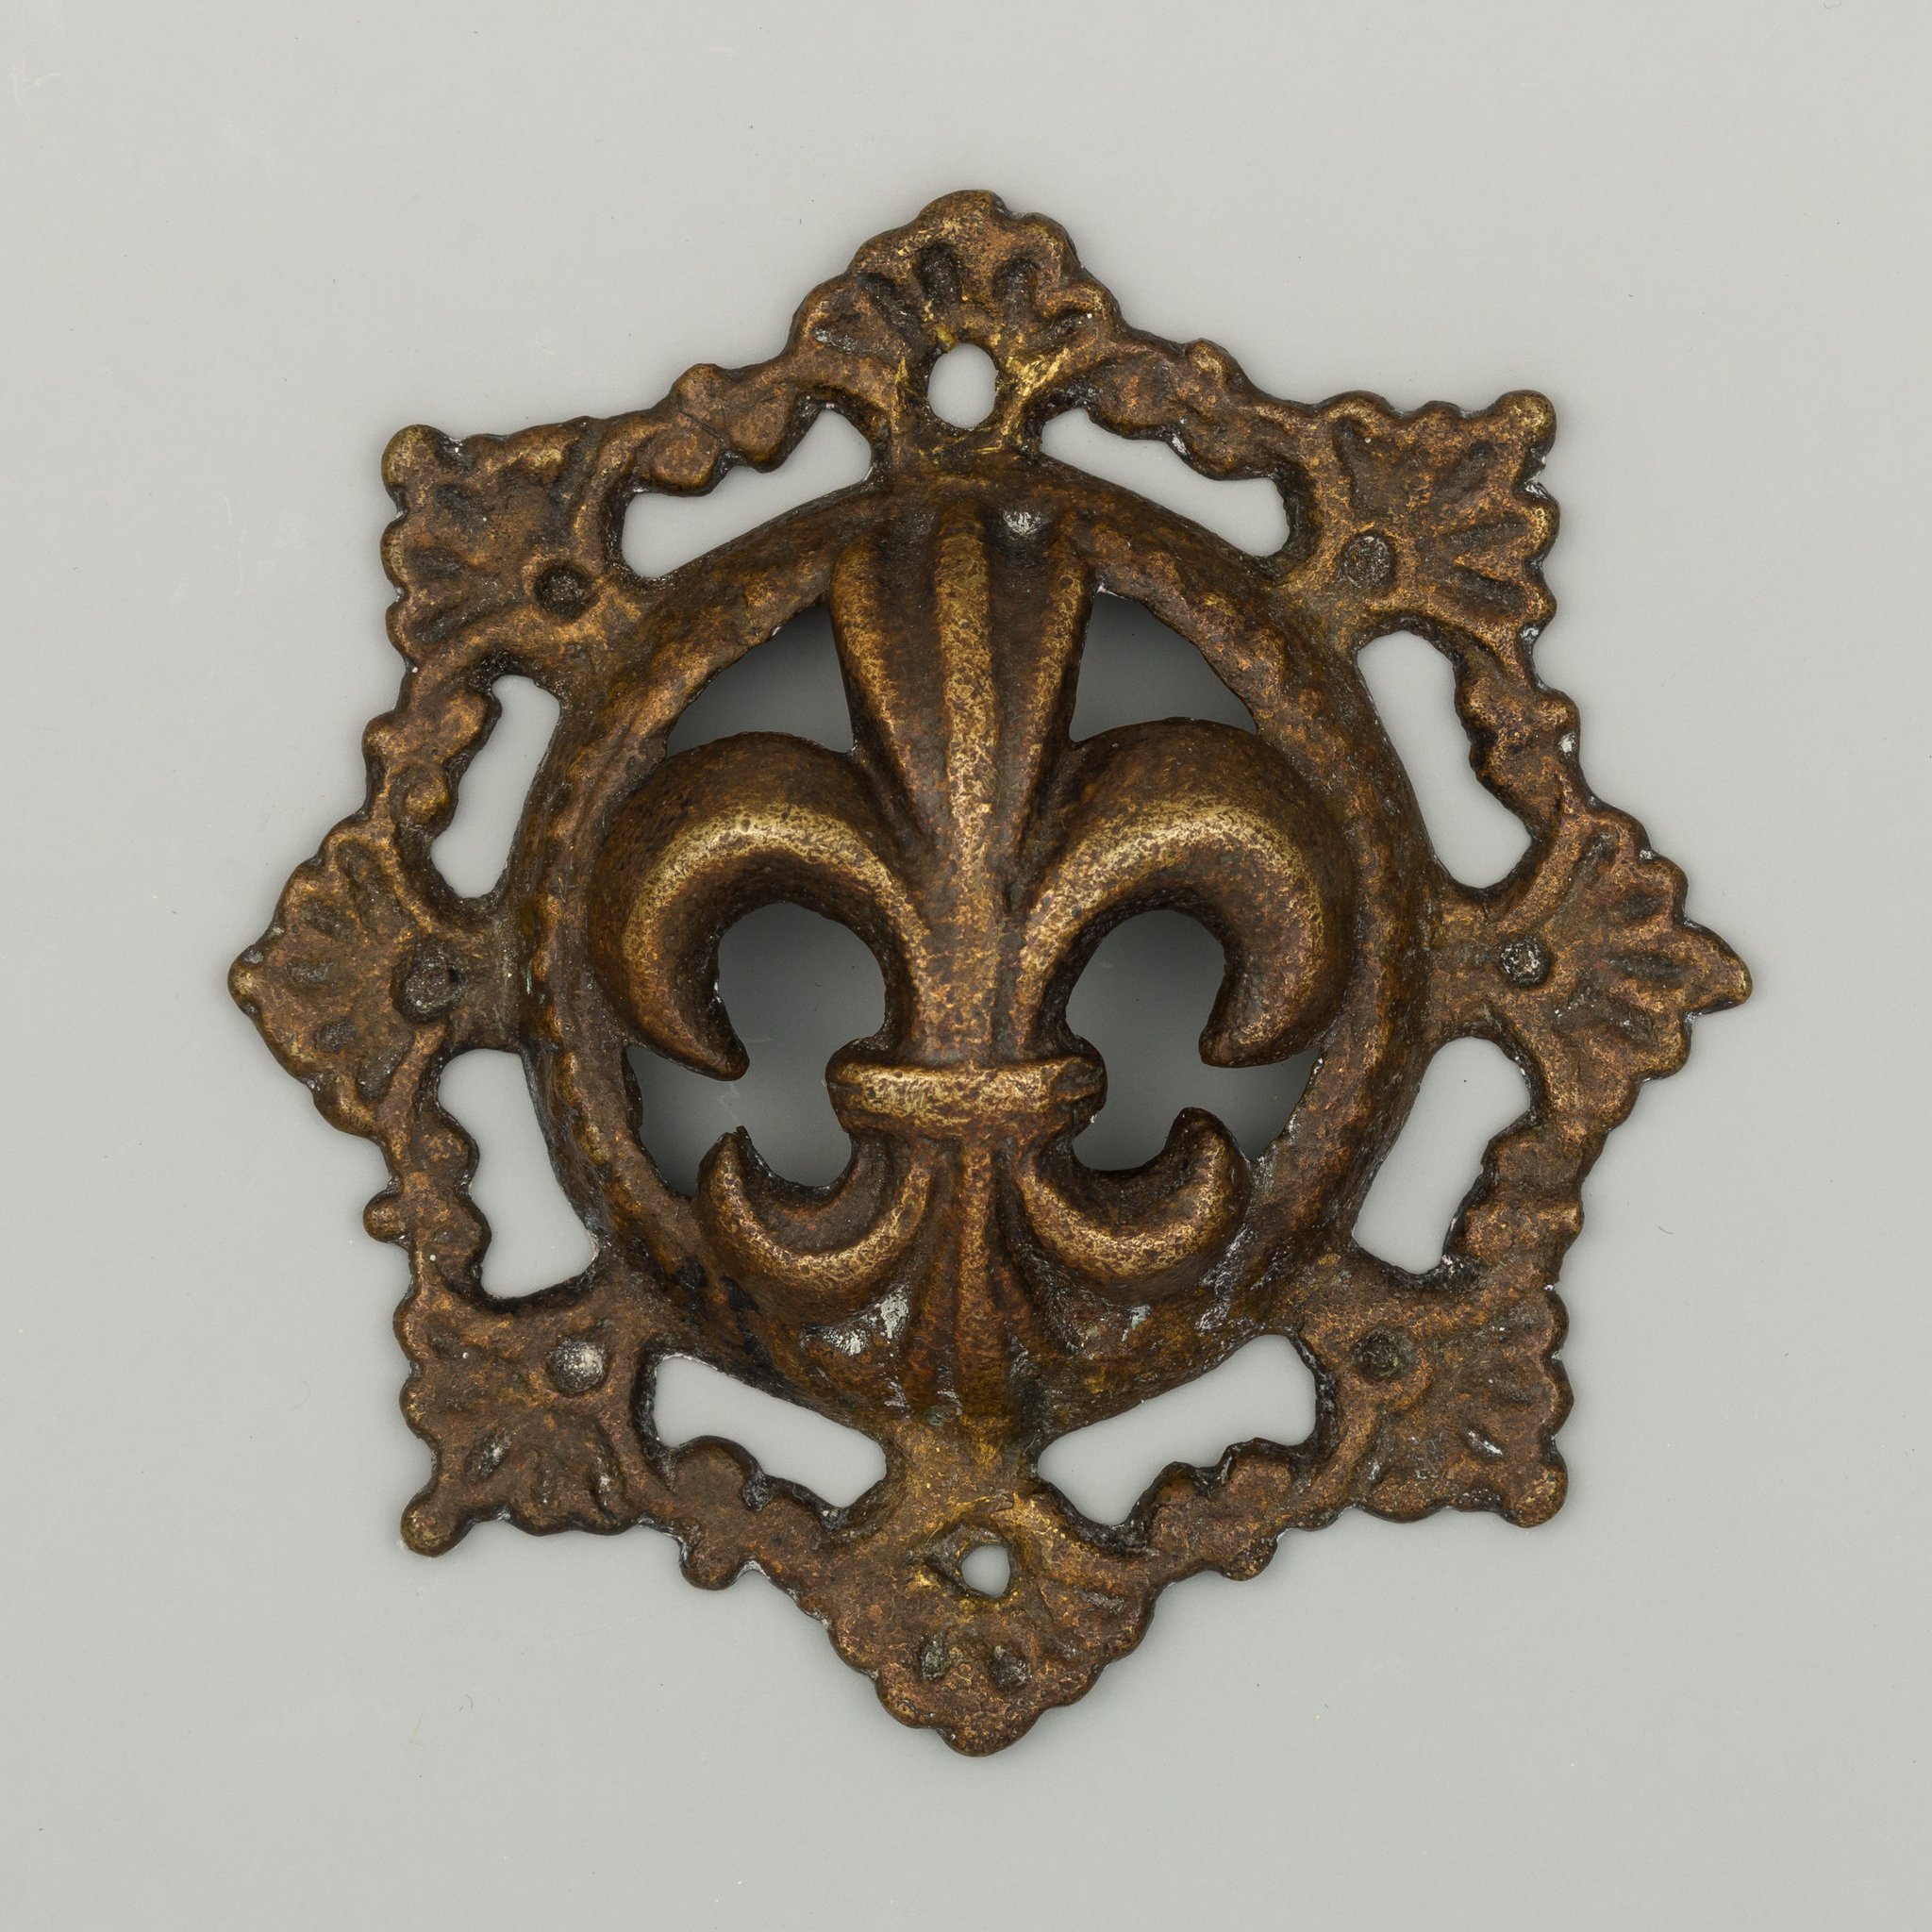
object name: bit bos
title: Bit Boss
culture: dutch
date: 1601-1650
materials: copper alloy, gold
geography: netherlands